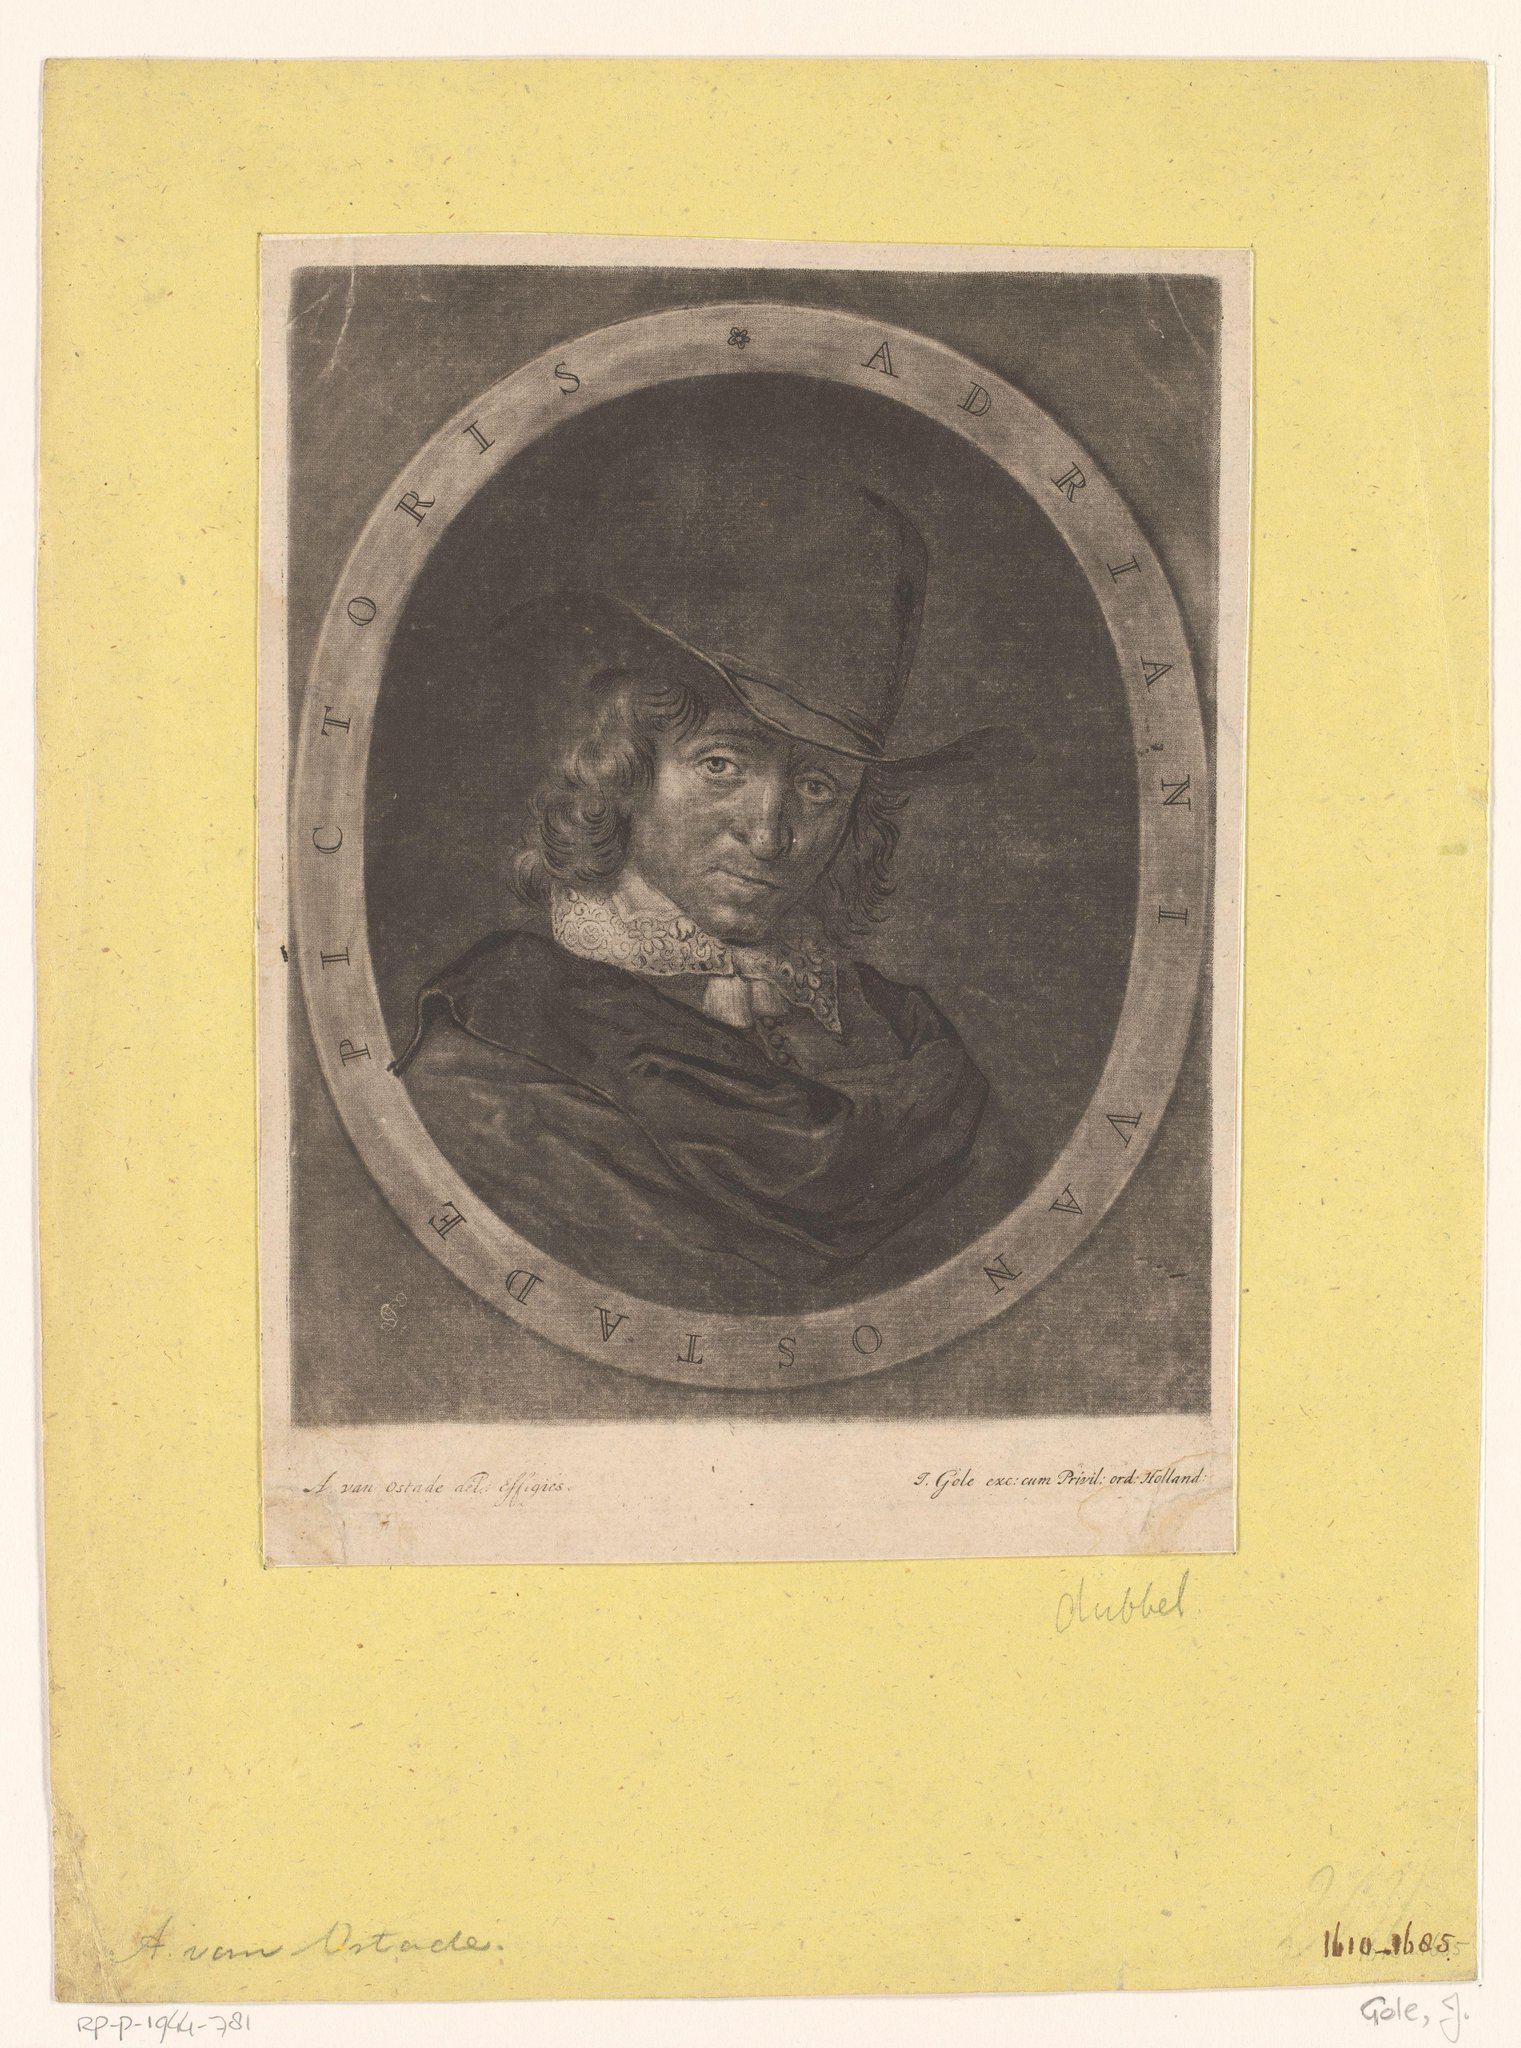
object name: print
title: Portret van Adriaen van Ostade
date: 1682-1723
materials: paper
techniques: etching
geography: amsterdam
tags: haarlem, adriaen van ostade, ornament ~ medallion, historical persons, head-gear: hat, portrait, self-portrait of painter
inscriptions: inscription: ‘in Franken aanwezig/ Gm’, collector's mark: Lugt 2228